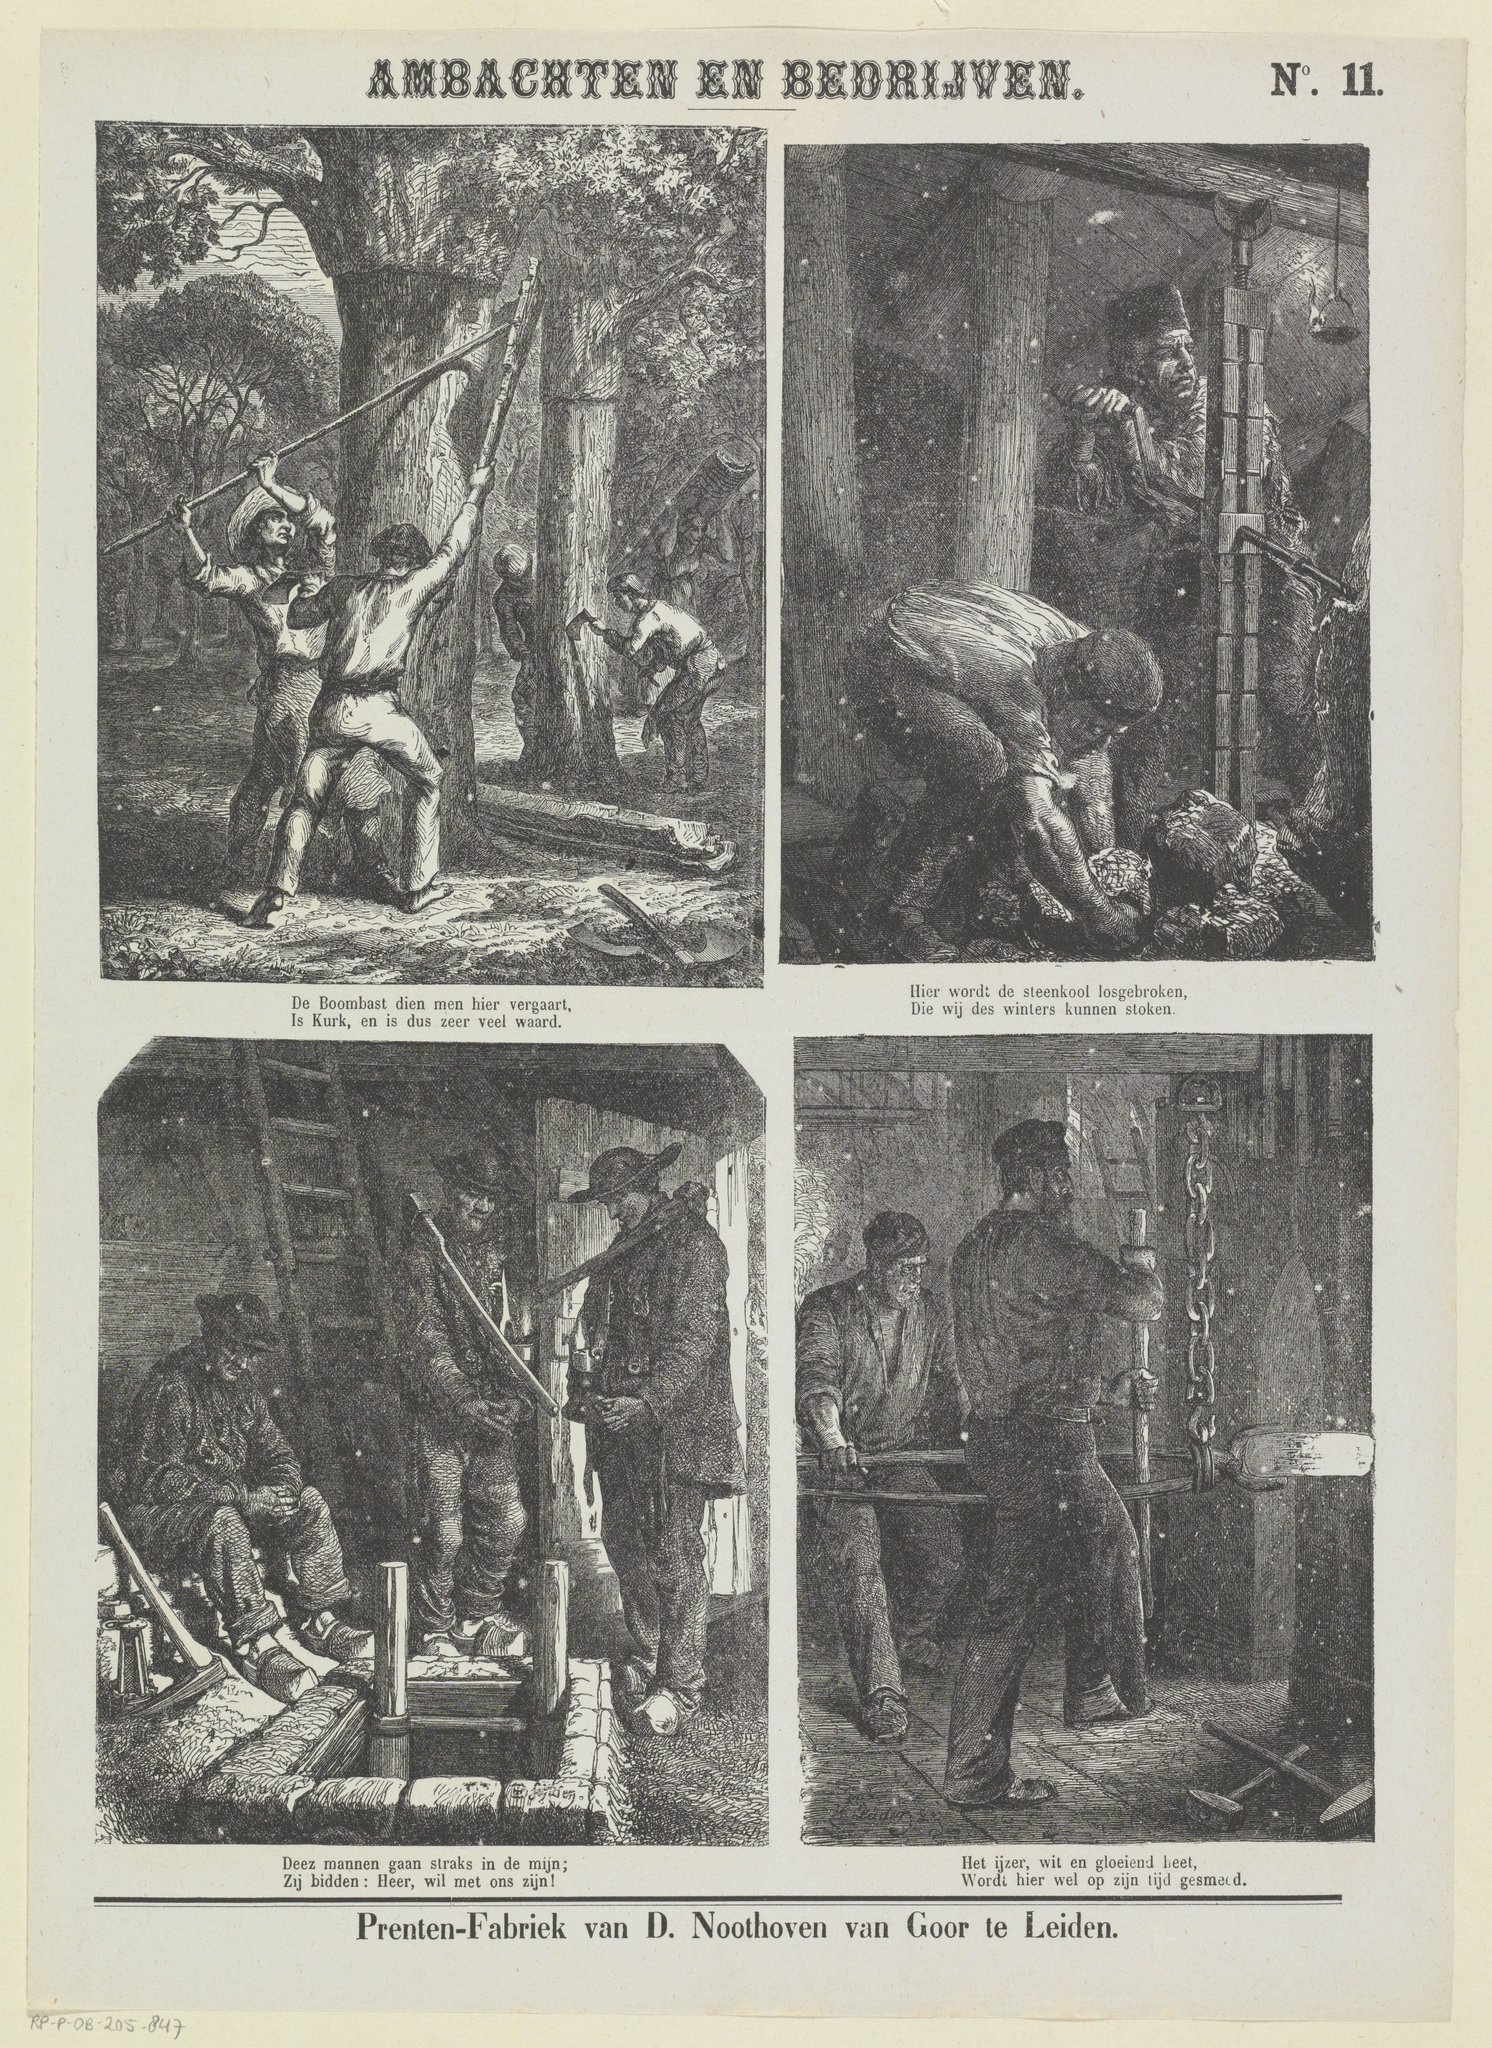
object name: popular print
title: Ambachten en bedrijven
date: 1850-1881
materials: paper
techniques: letterpress printing, engraving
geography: leiden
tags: miner, smith, blacksmith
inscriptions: collector's mark: Lugt 2760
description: Blad met 4 voorstellingen van beroepen, zoals mijnwerker en smid. Onder elke voorstelling een tweeregelig vers. Genummerd rechtsboven: No. 11.